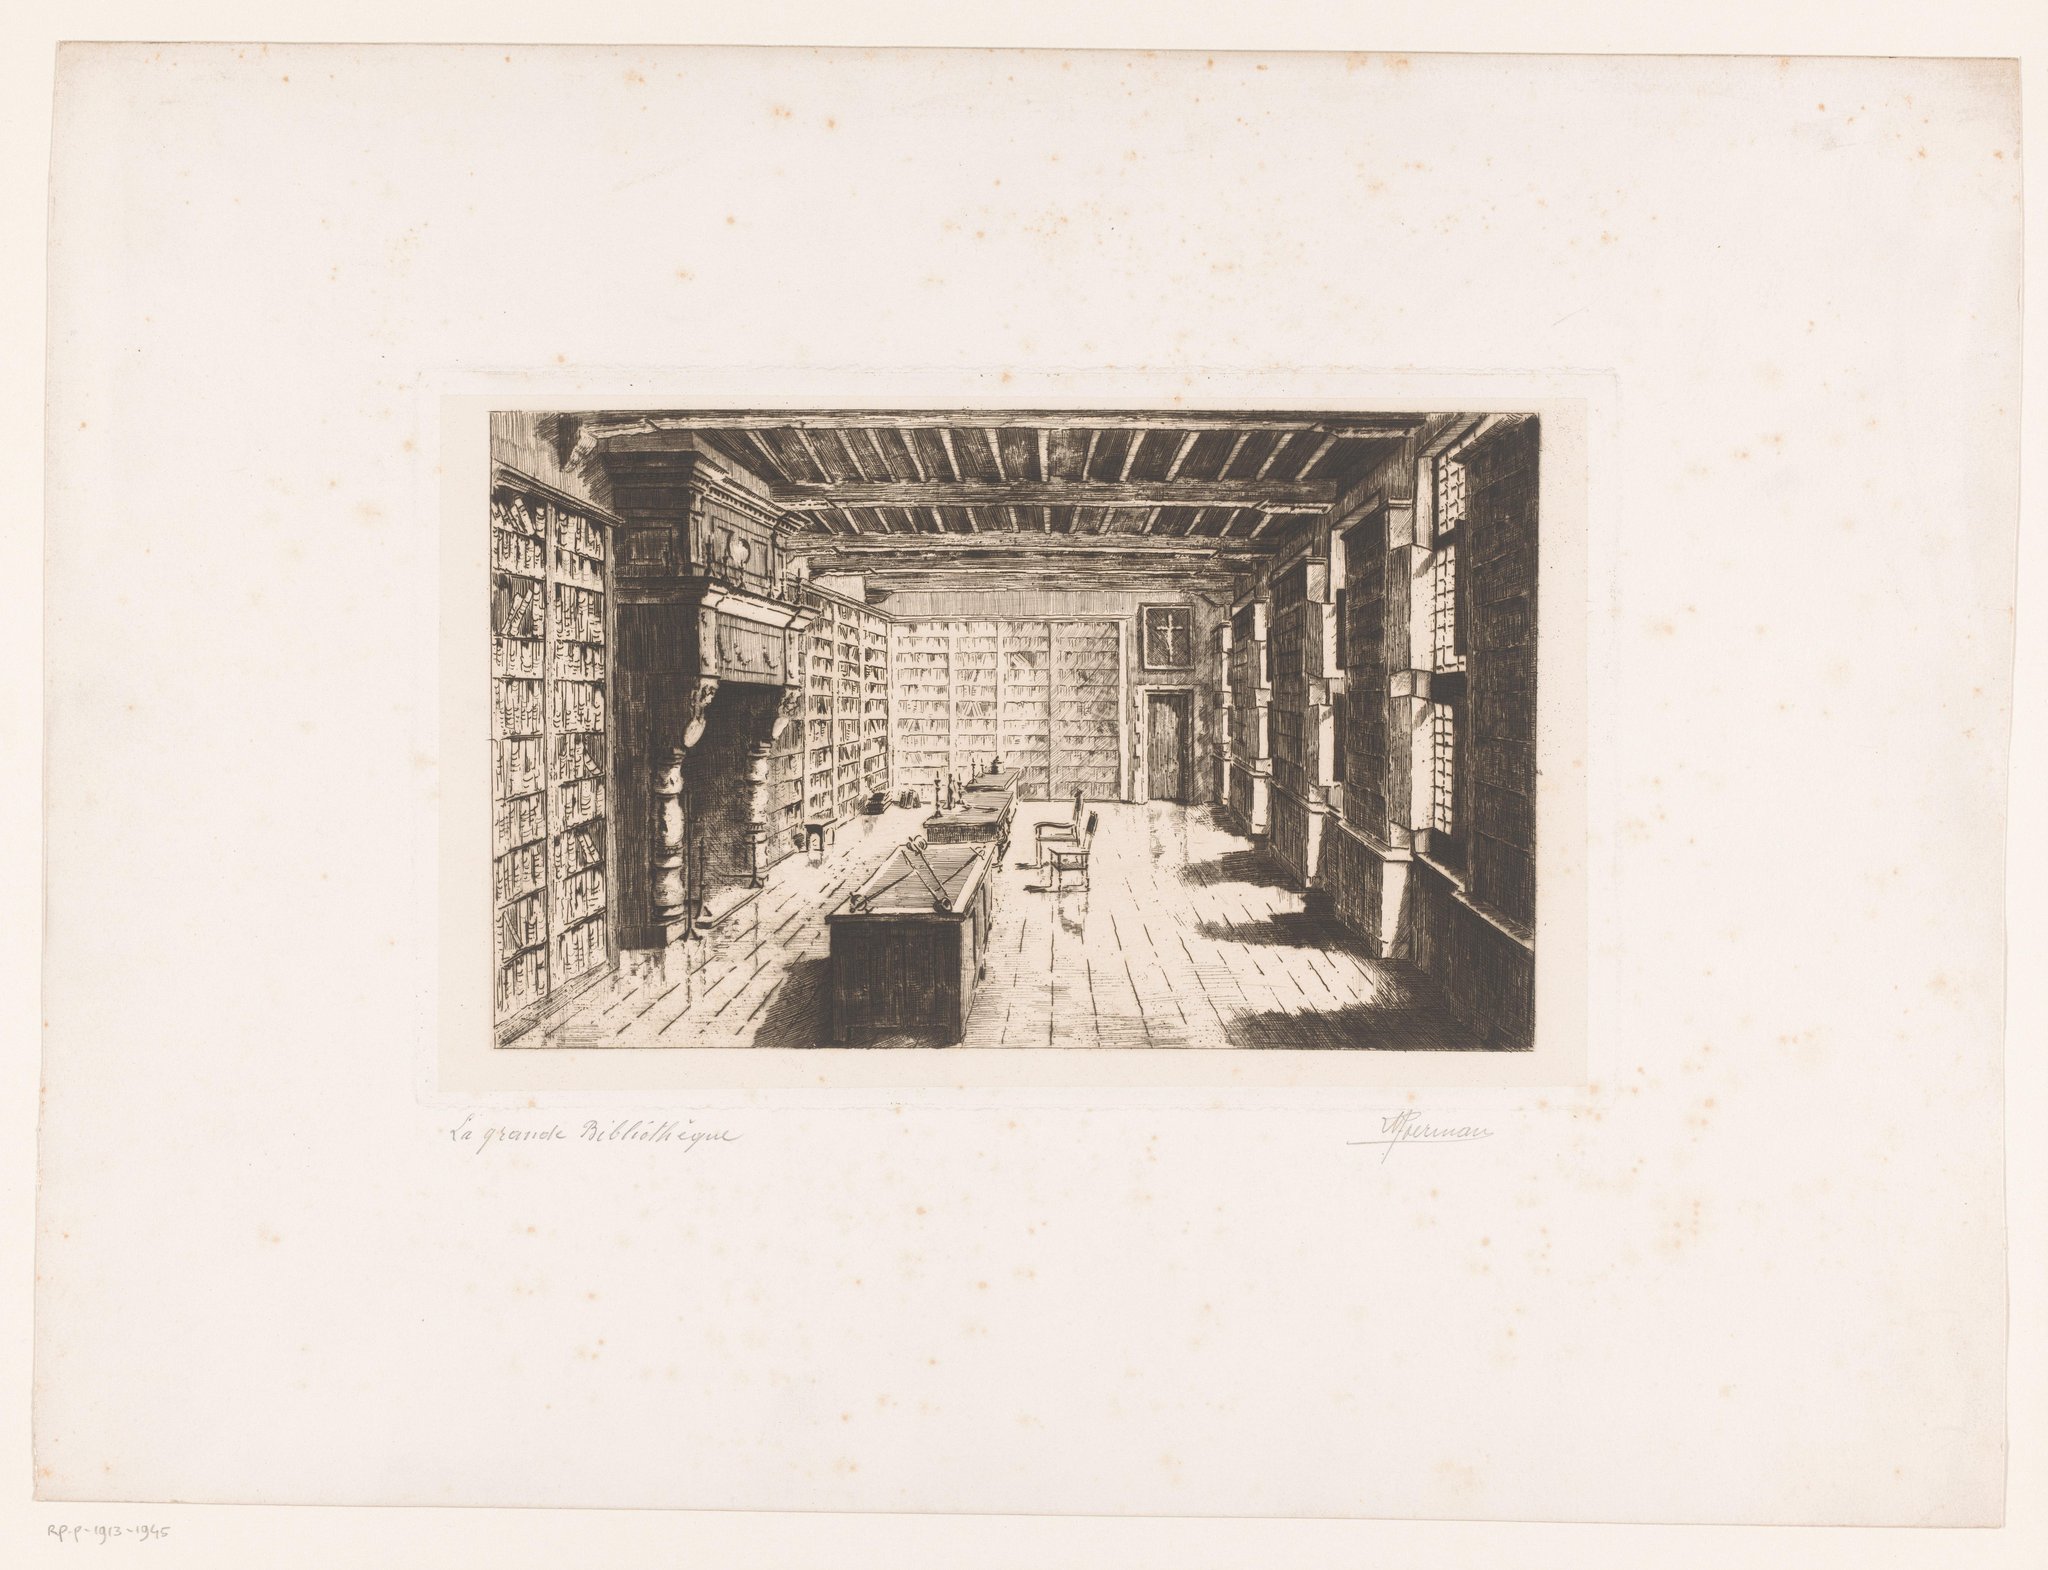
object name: print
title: Bibliotheekzaal met schouw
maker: l. moerman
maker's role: print maker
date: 1850-1899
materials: paper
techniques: drypoint, etching, intaglio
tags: open hearth, fire-place, study; 'studiolo'; library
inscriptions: collector's mark: Lugt 2228